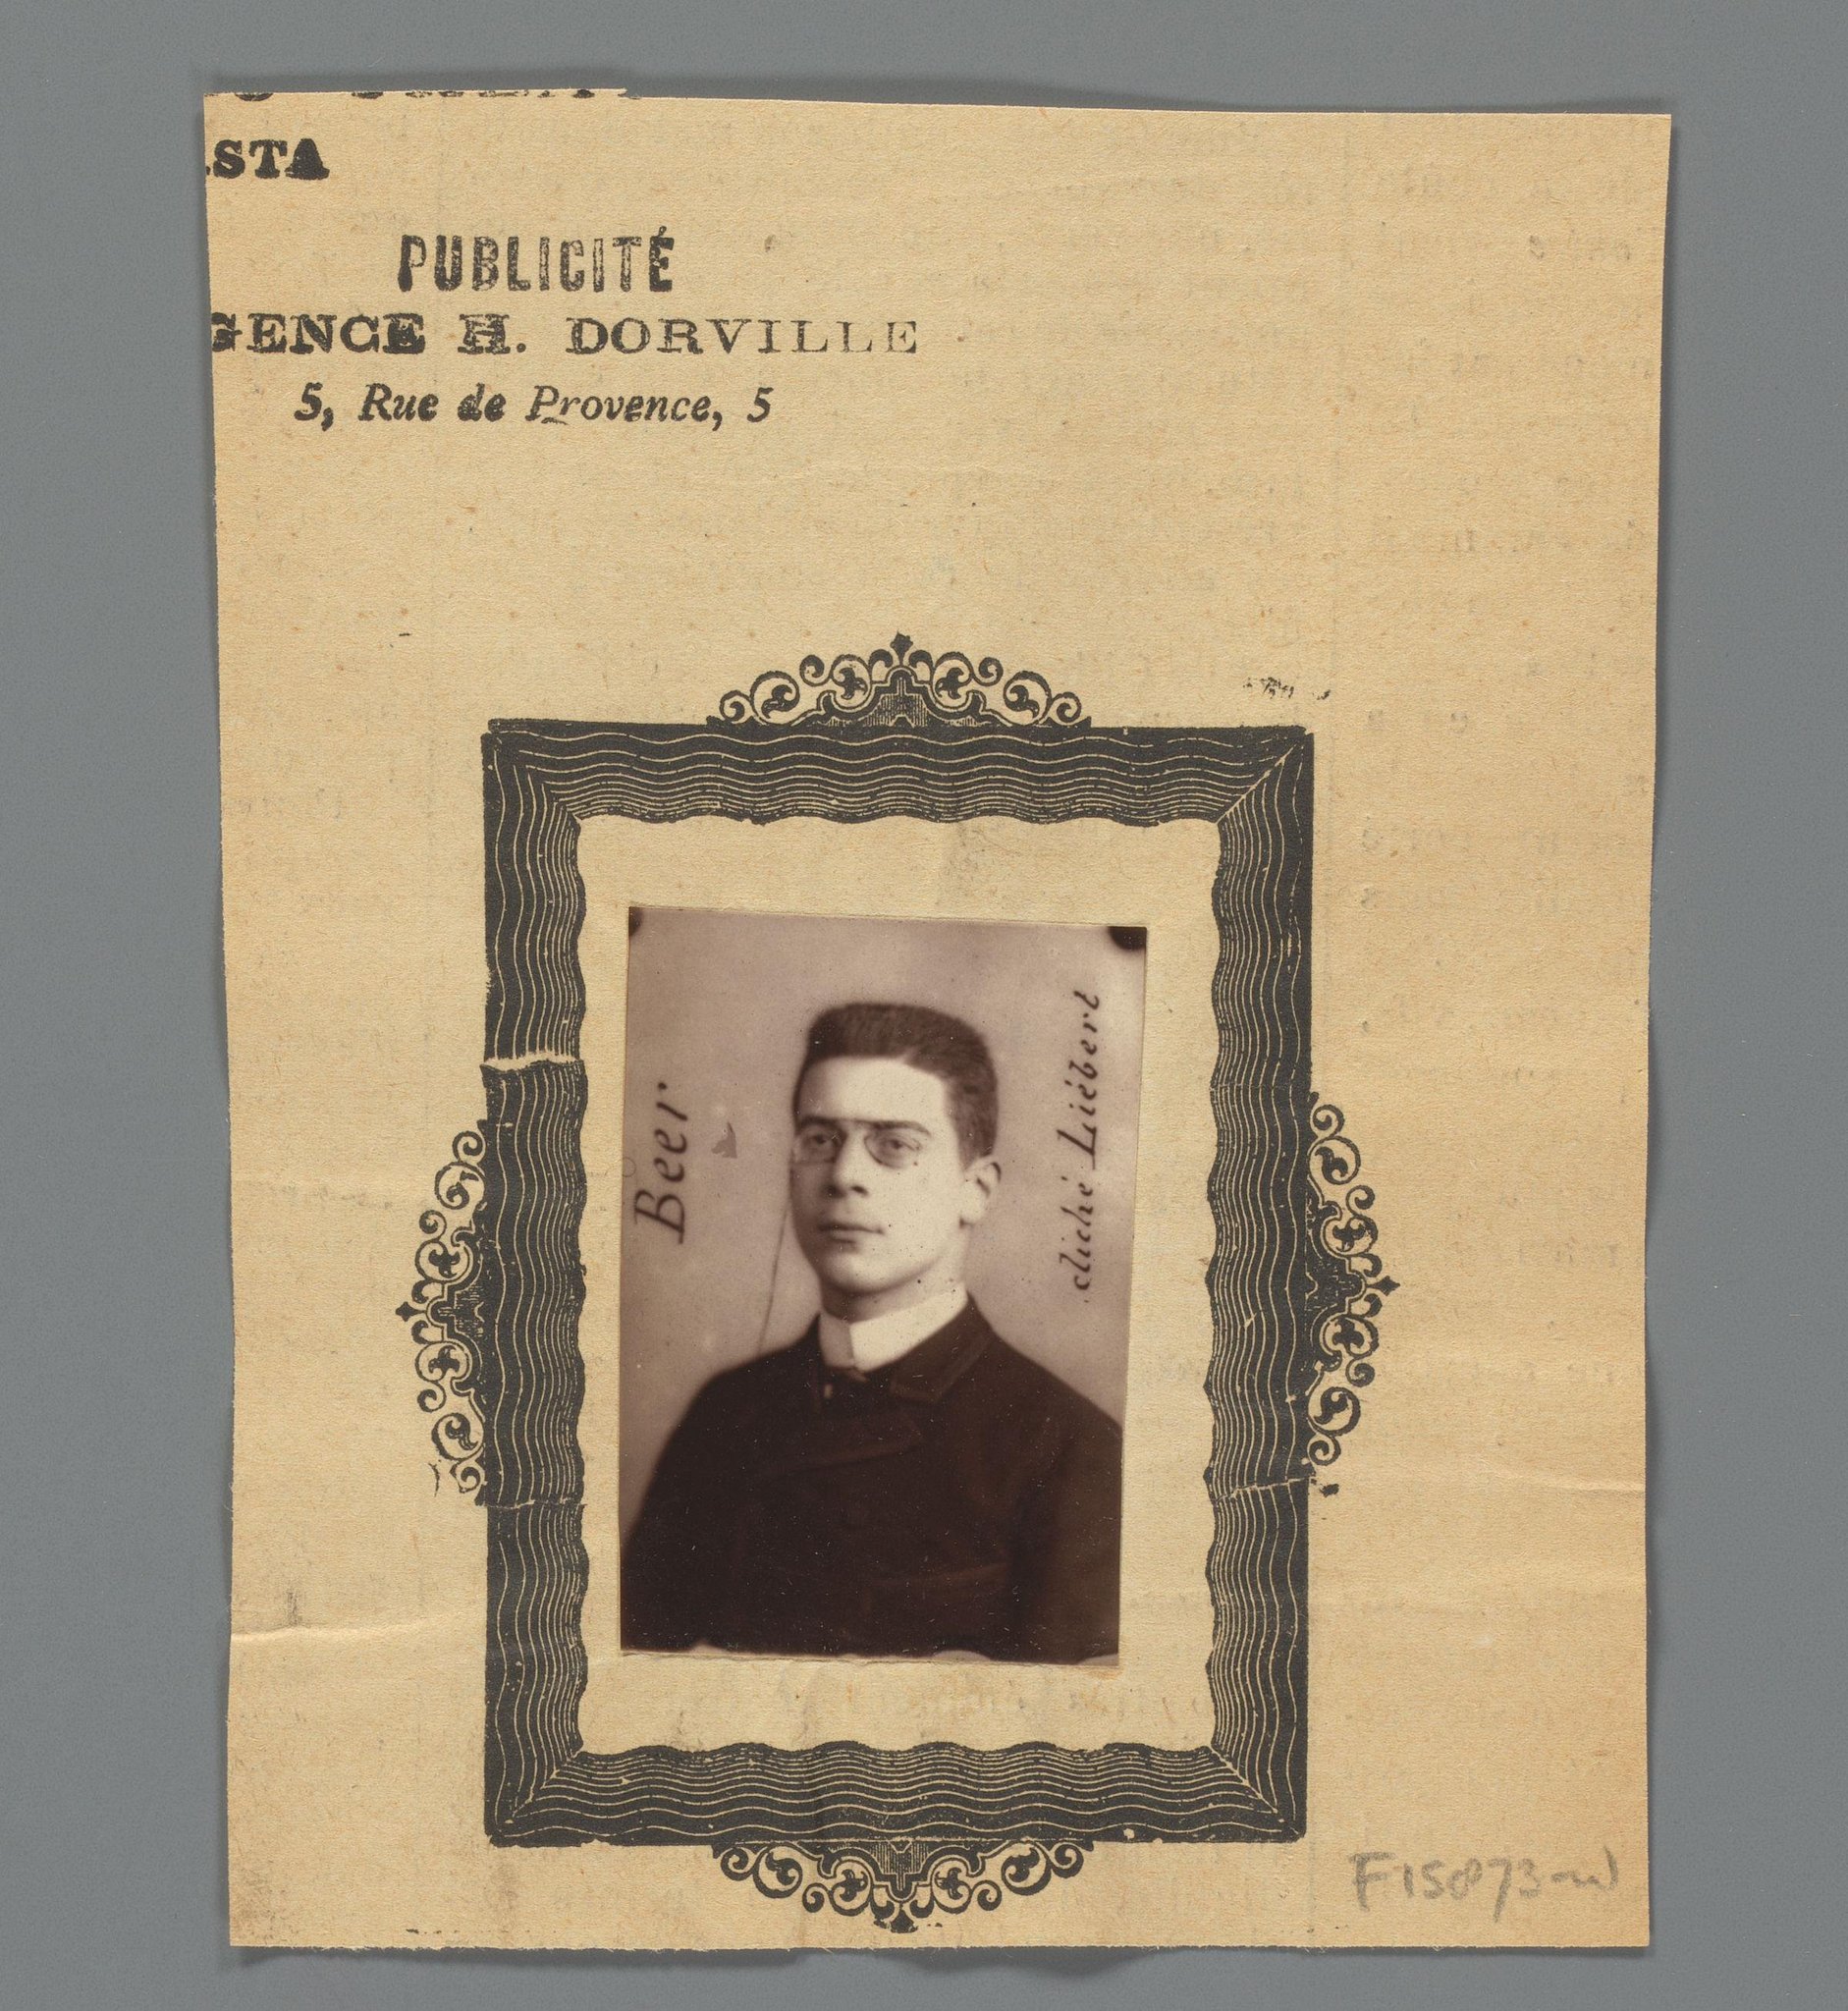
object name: photograph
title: Portret van een onbekende man, aangeduid als Beer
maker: alphonse-justin liébert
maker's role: fotograaf, marinier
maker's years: 1827-1914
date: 1880-1910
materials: paper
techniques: albumen print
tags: anonymous historical person portrayed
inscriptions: inscription: ‘Beer/ cliché Liébert’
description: Knipsel uit 'Les Folies-Bergèr, journal spécial au théâtre' met een opgeplakt fotoportret.